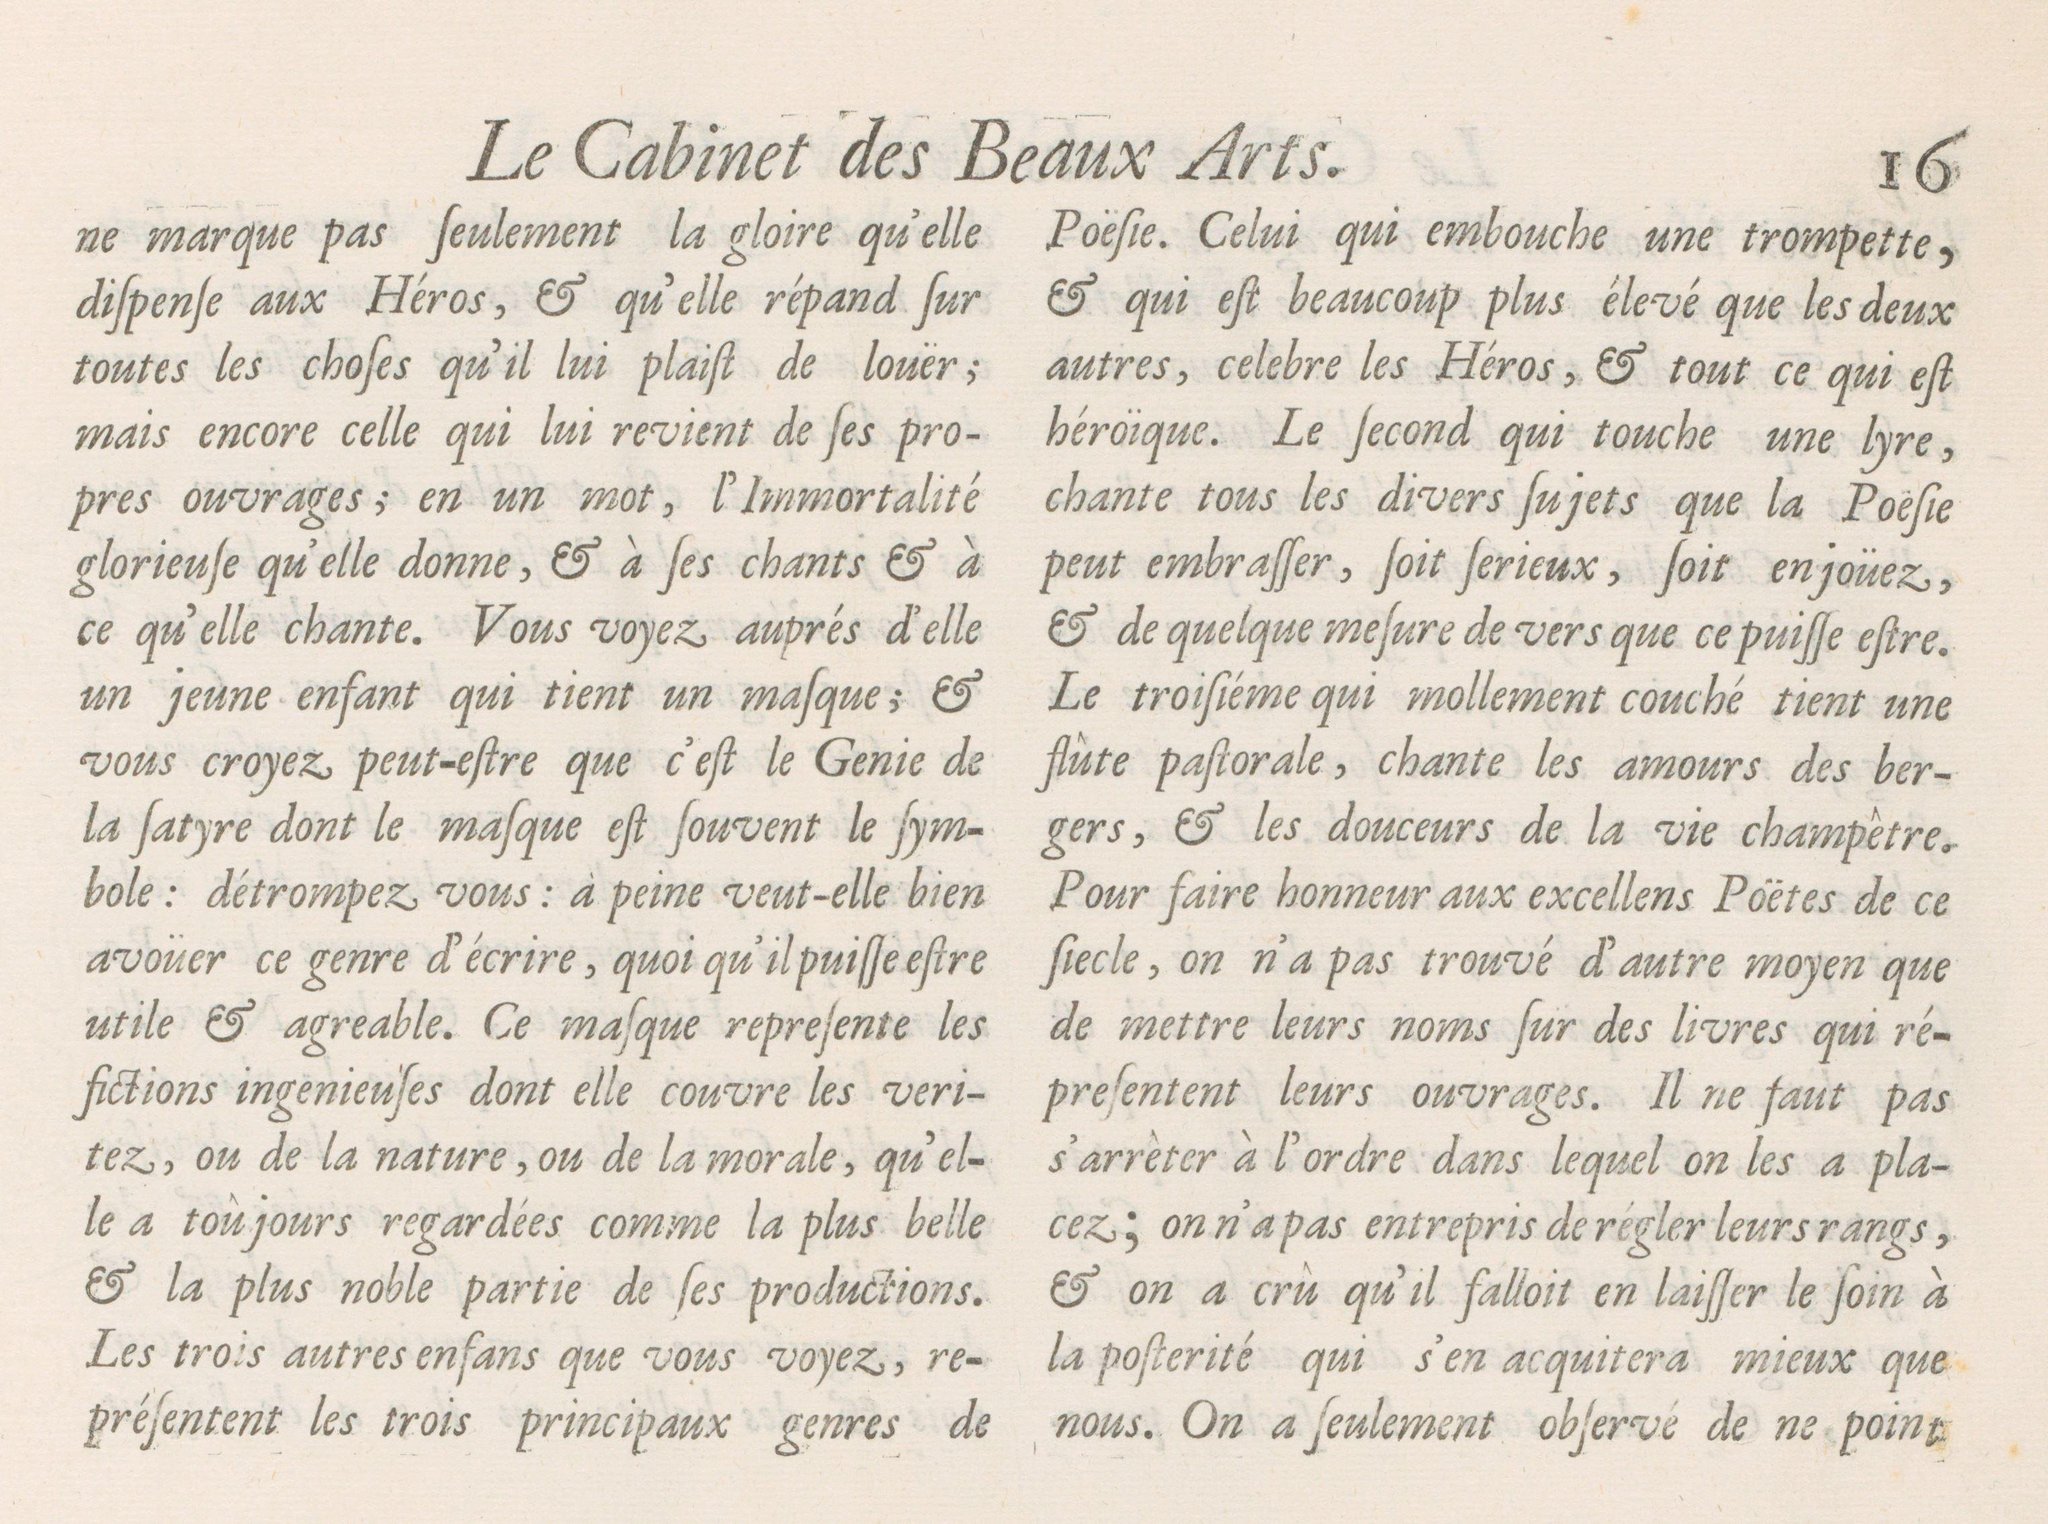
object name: album leaf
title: Tekstblad met verklaring van de prent over Dichtkunst, p. 16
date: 1695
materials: paper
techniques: letterpress printing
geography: paris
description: Verklaring van de prent met voorstelling van Poëzie of Dichtkunst in het Frans. Pagina 16. Tekstblad maakt deel uit van een album.